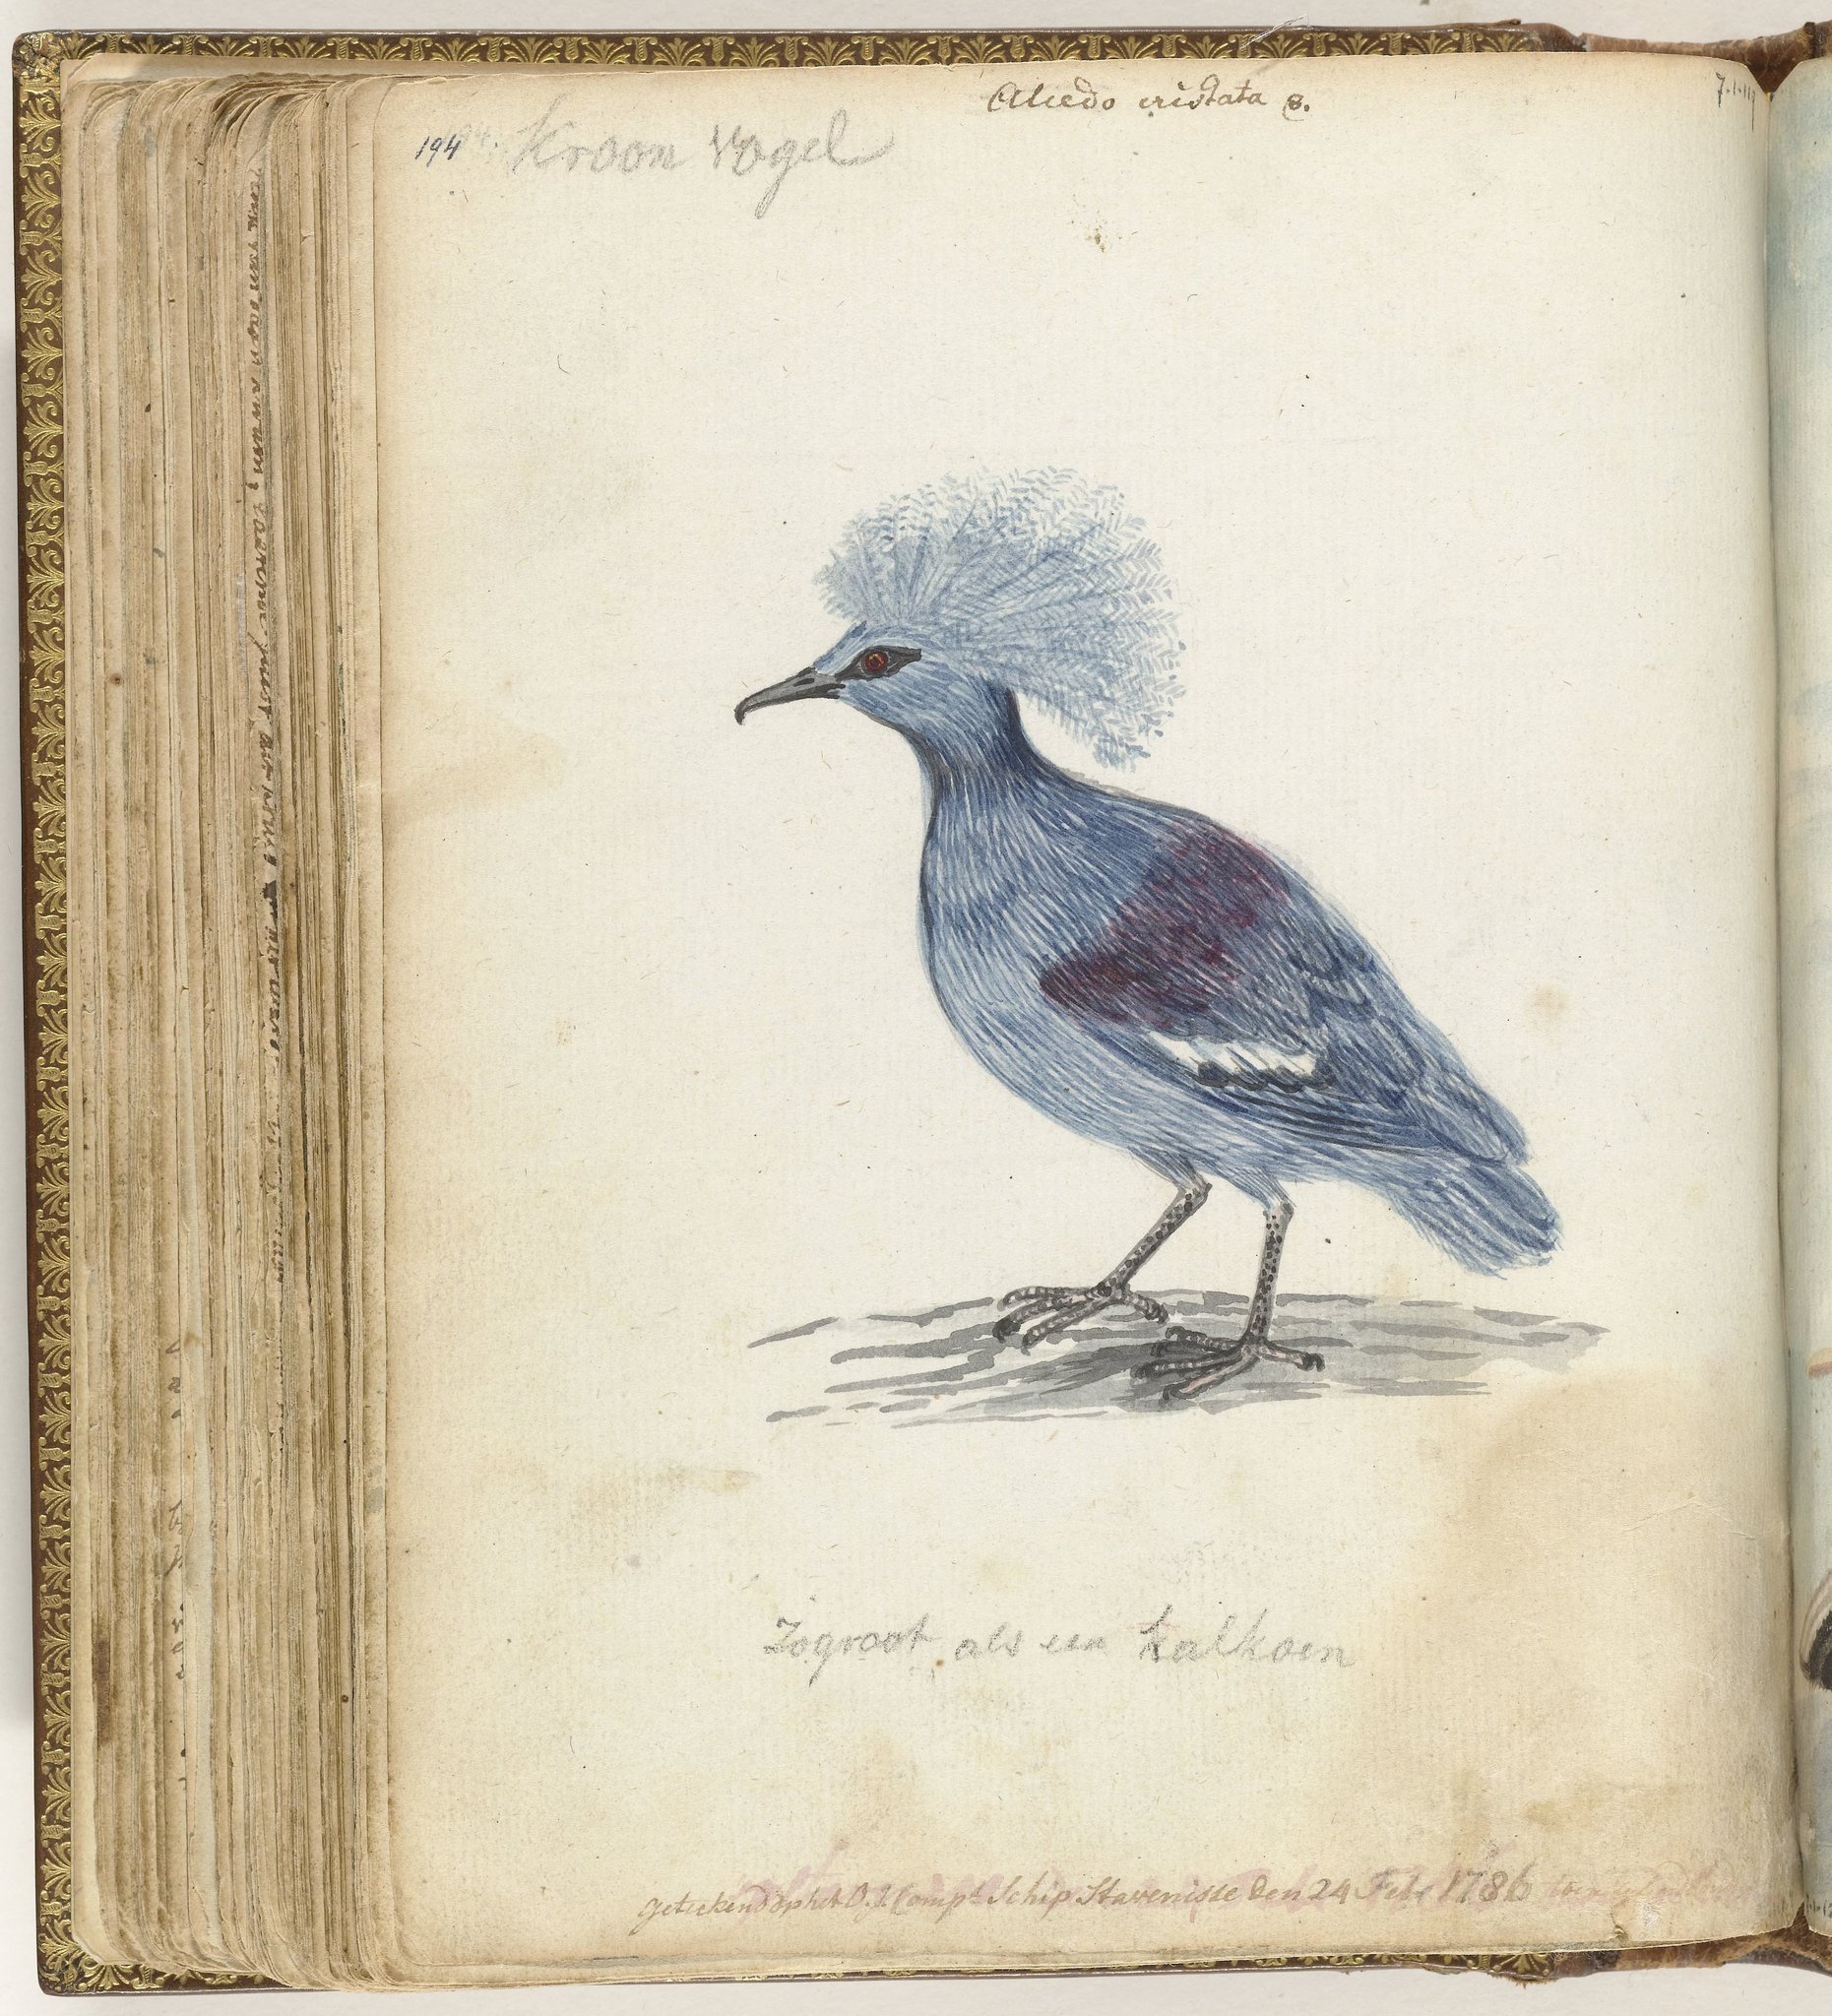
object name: drawing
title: Crowned Pigeon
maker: jan brandes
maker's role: draughtsman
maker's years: 1743-1808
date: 1786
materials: paper, pencil, watercolor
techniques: brush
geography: indian ocean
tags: ornamental birds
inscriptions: inscription: ‘Zo groot als een kalkoen / geteekend op het O.I. Comp. schip Stavenisse den 24 Febr 1786 [...]’, inscription: ‘kroonvogel / Alcedo cristata ß’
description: Kleurtekening van kroonduif, 'zo groot als een kalkoen'. Met opschrift. Onderdeel uit het schetsboek van Jan Brandes, dl. 1 (1808), p. 194.